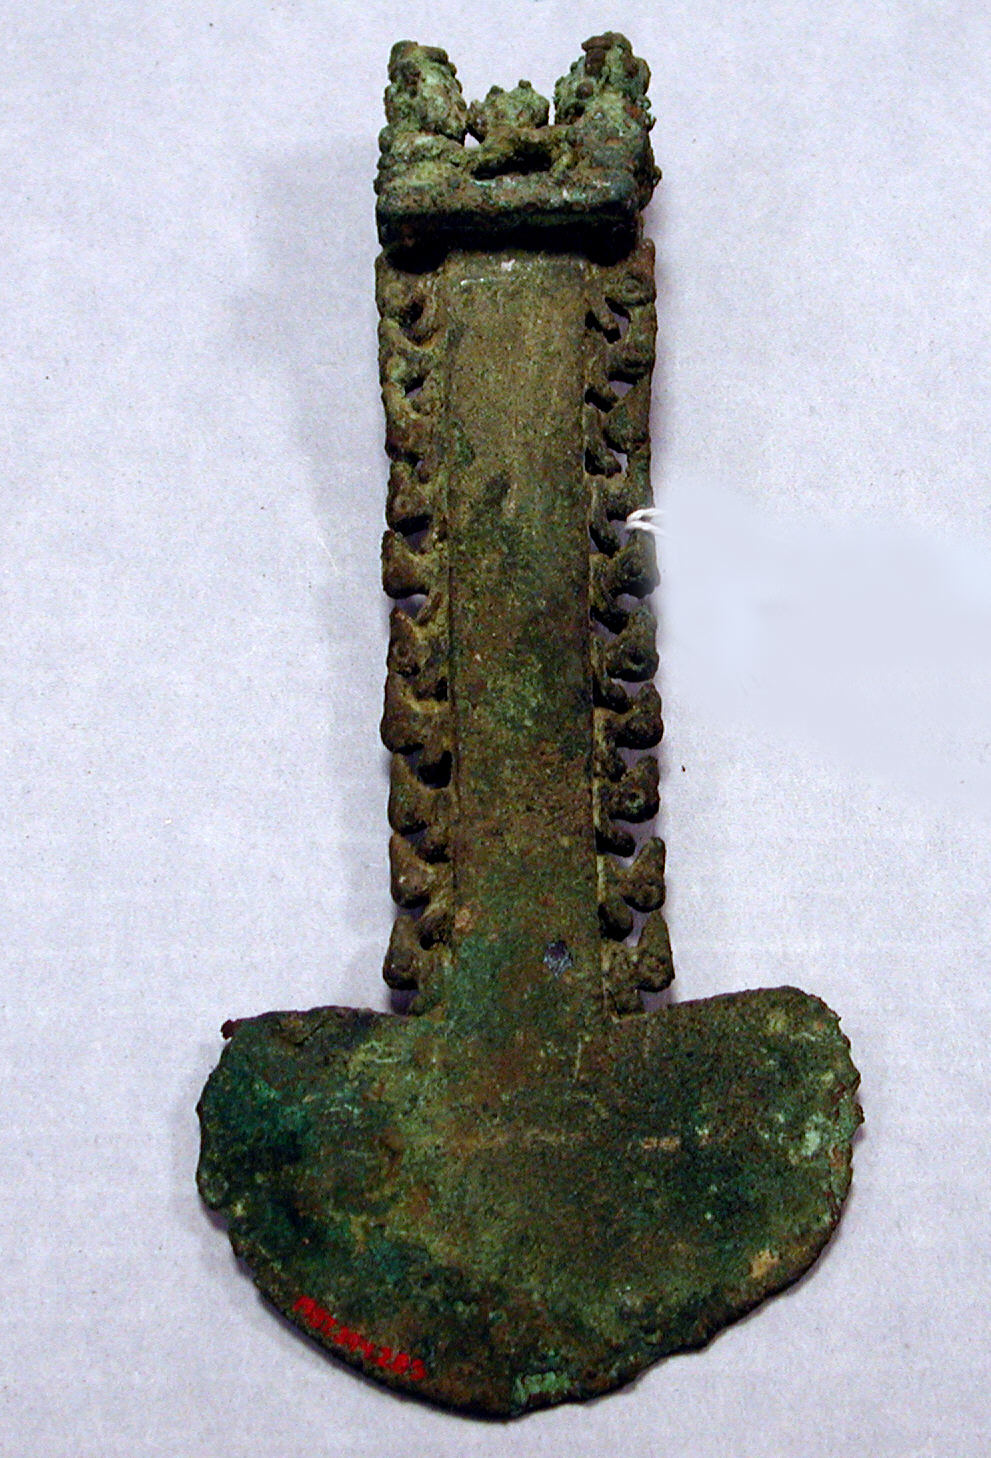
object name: knife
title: Ceremonial Knife (Tumi)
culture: peruvian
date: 601-1500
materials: copper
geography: peru